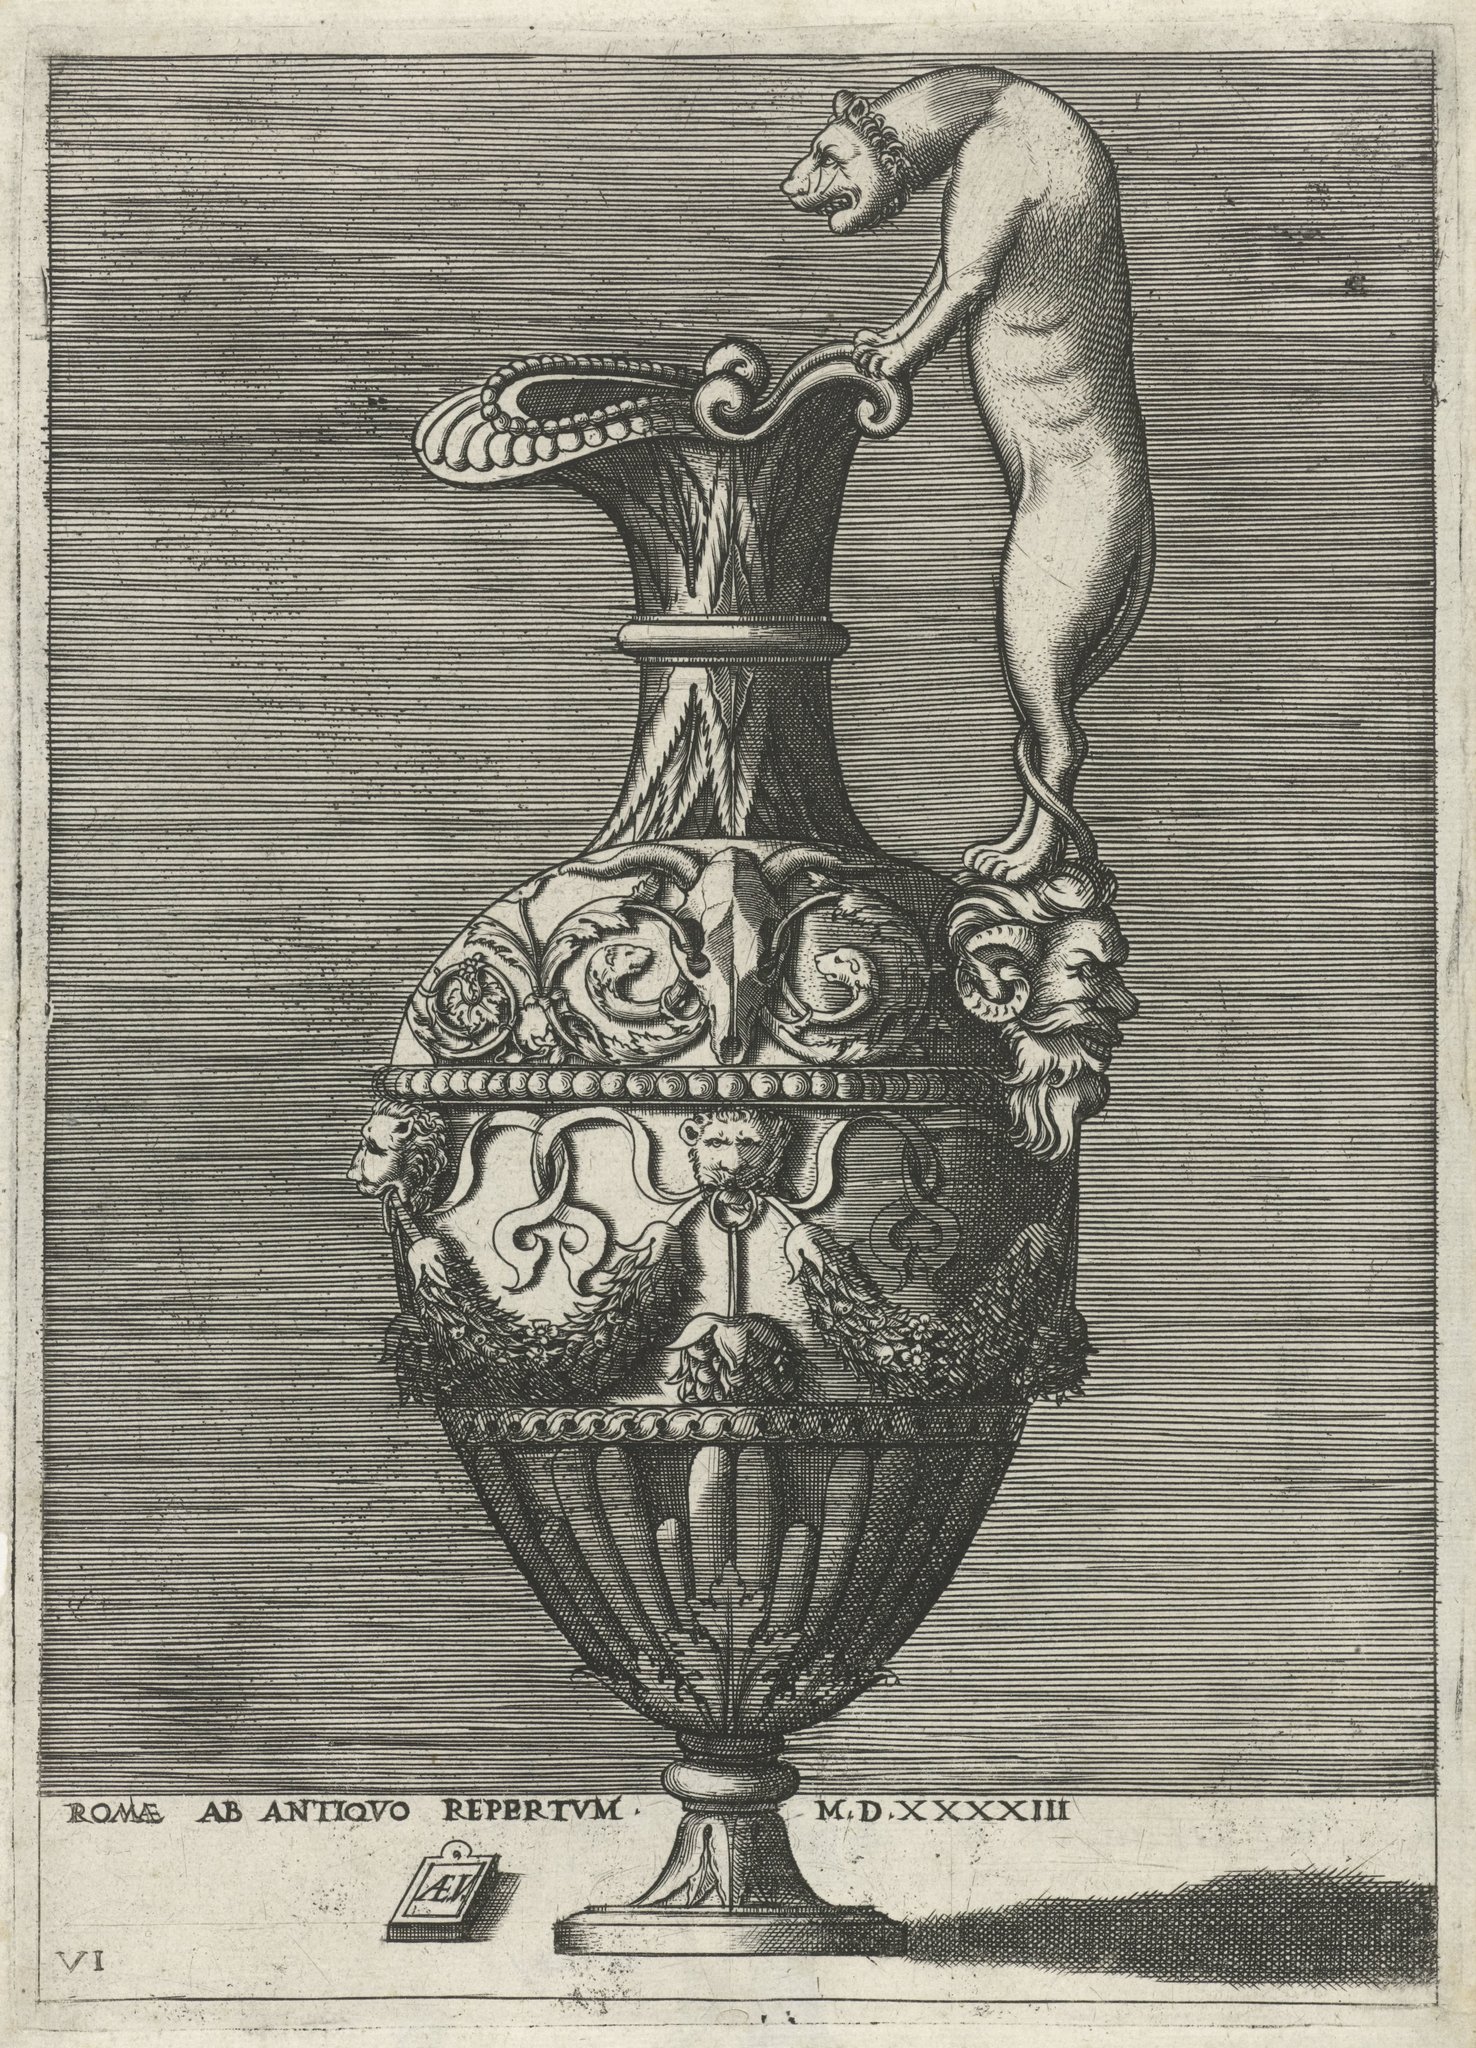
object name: print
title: Kan met een oor in de vorm van een hond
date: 1533-1567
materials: paper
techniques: engraving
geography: italy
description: De buik van de kan is gedecoreerd met een dierschedel tussen bladranken. Uit serie van 14 deels genummerde bladen. De vazen hebben vermoedelijk antieke vazen als uitgangspunt gehad.